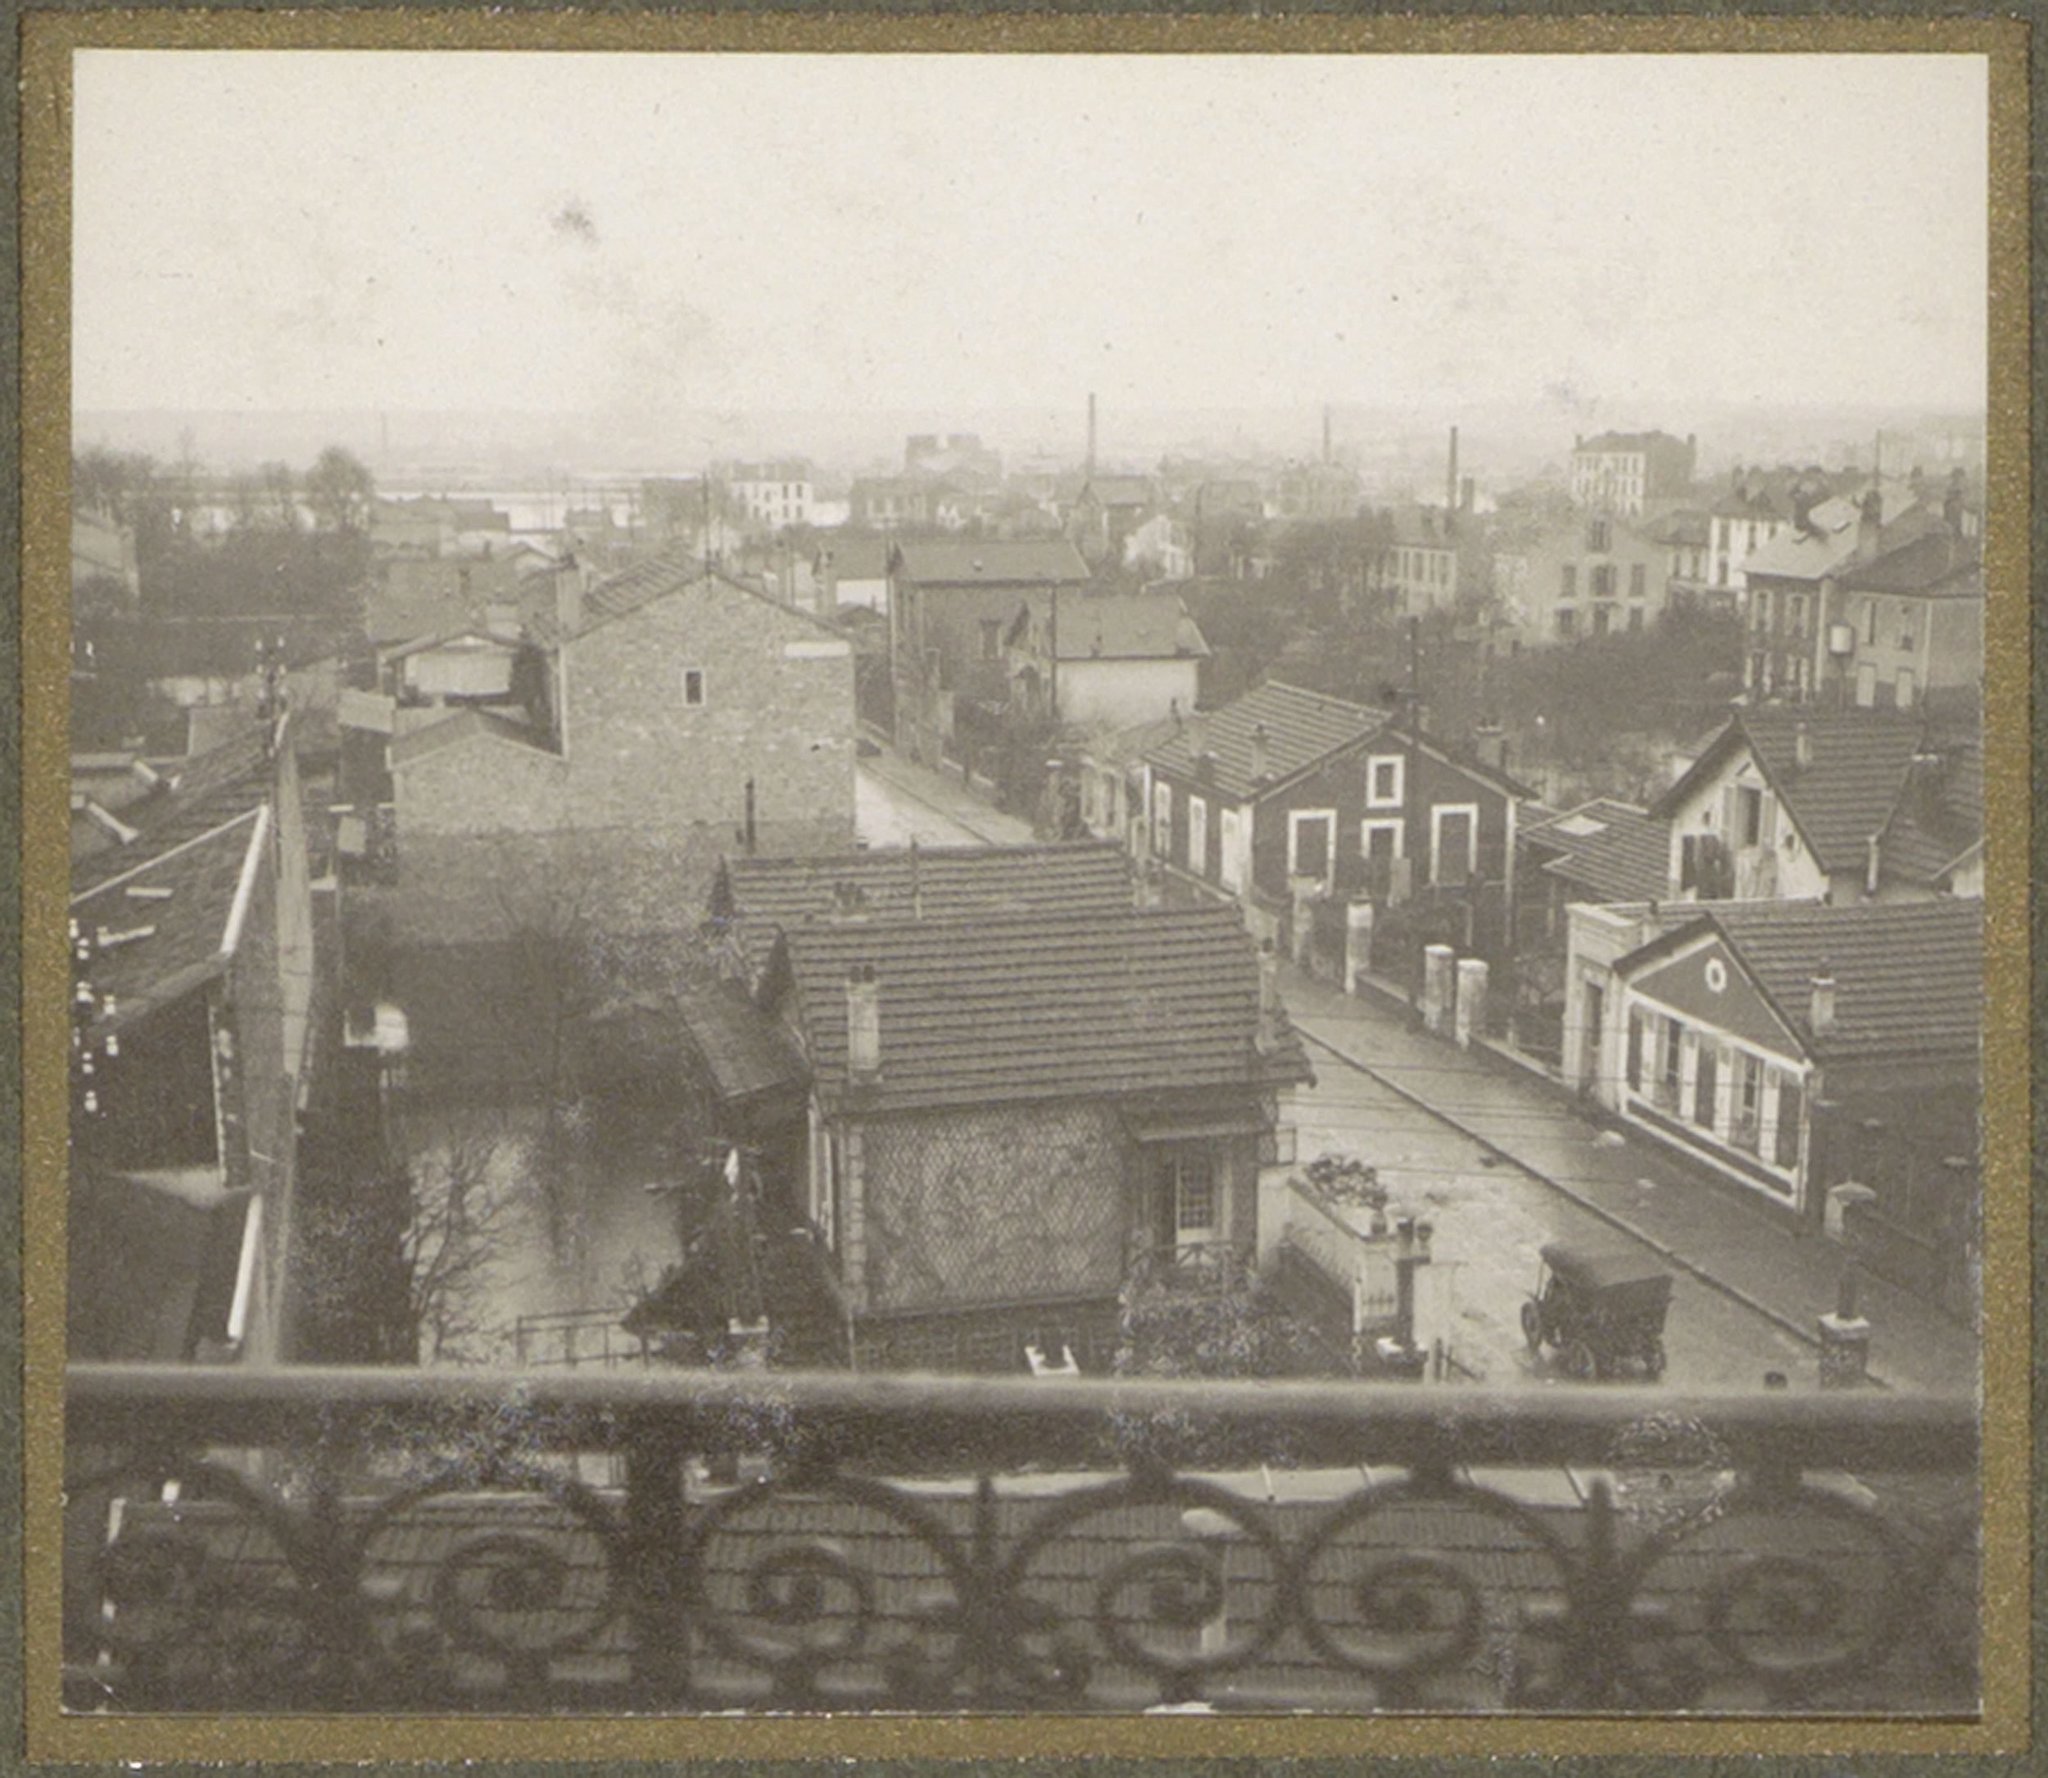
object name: photograph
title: Ondergelopen buitenwijk van Parijs gezien vanuit een venster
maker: g. dangereux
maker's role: fotograaf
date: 1901-1910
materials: photographic support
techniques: matte daylight collodion silver print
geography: paris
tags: flood (+ landscape with figures, staffage), paris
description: Onderdeel van fotoalbum overstroming Parijs en voorsteden 1910.